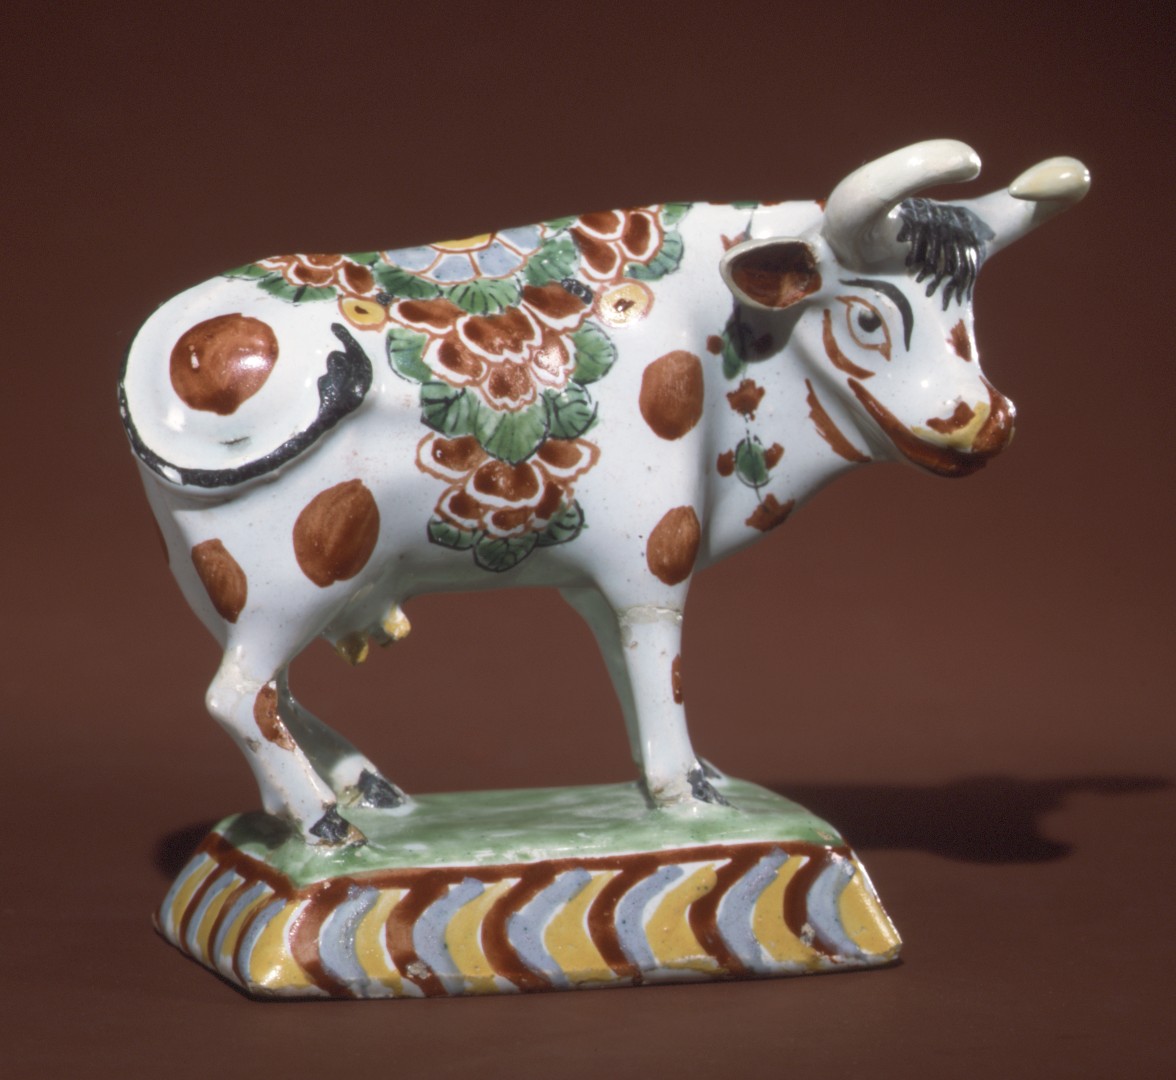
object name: figure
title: Cow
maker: anthoni pennis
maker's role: maker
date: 1701-1800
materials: earthenware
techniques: glazing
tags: cows